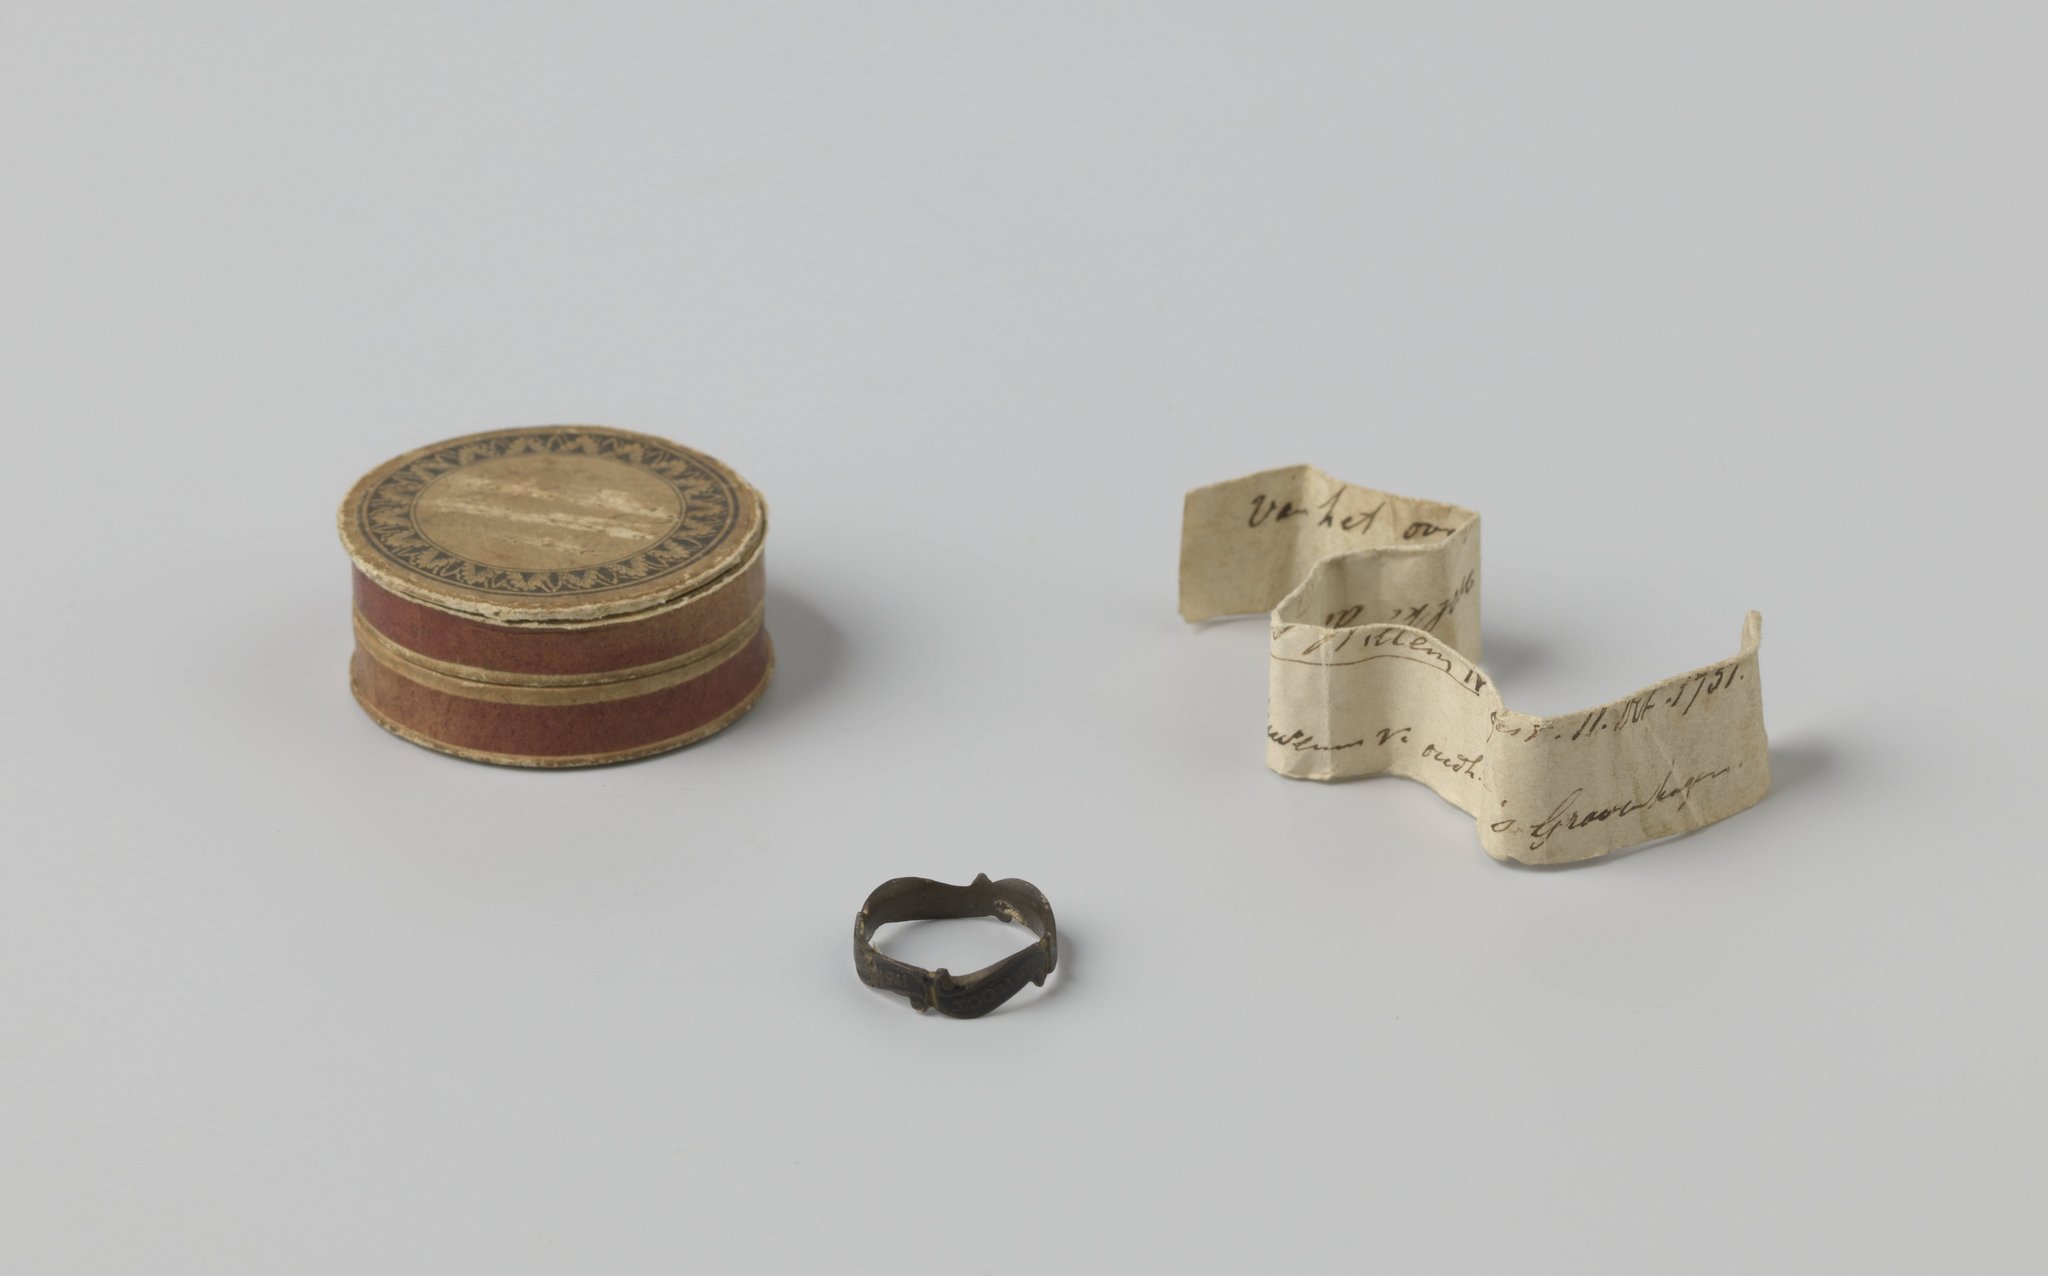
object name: ring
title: Rouwring Willem IV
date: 1751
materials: iron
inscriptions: : ‘OB: 11 OCT - 1751:[onleesbaar] - GUL:NASS - PRIN:AUR’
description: Rouwring Willem IV, gedragen door de hofdames na zijn overlijden. Op de ring het opschrift: "OB:11 OCT - 1751:[onleesbaar] - GUL:NASS - PRIN:AUR"